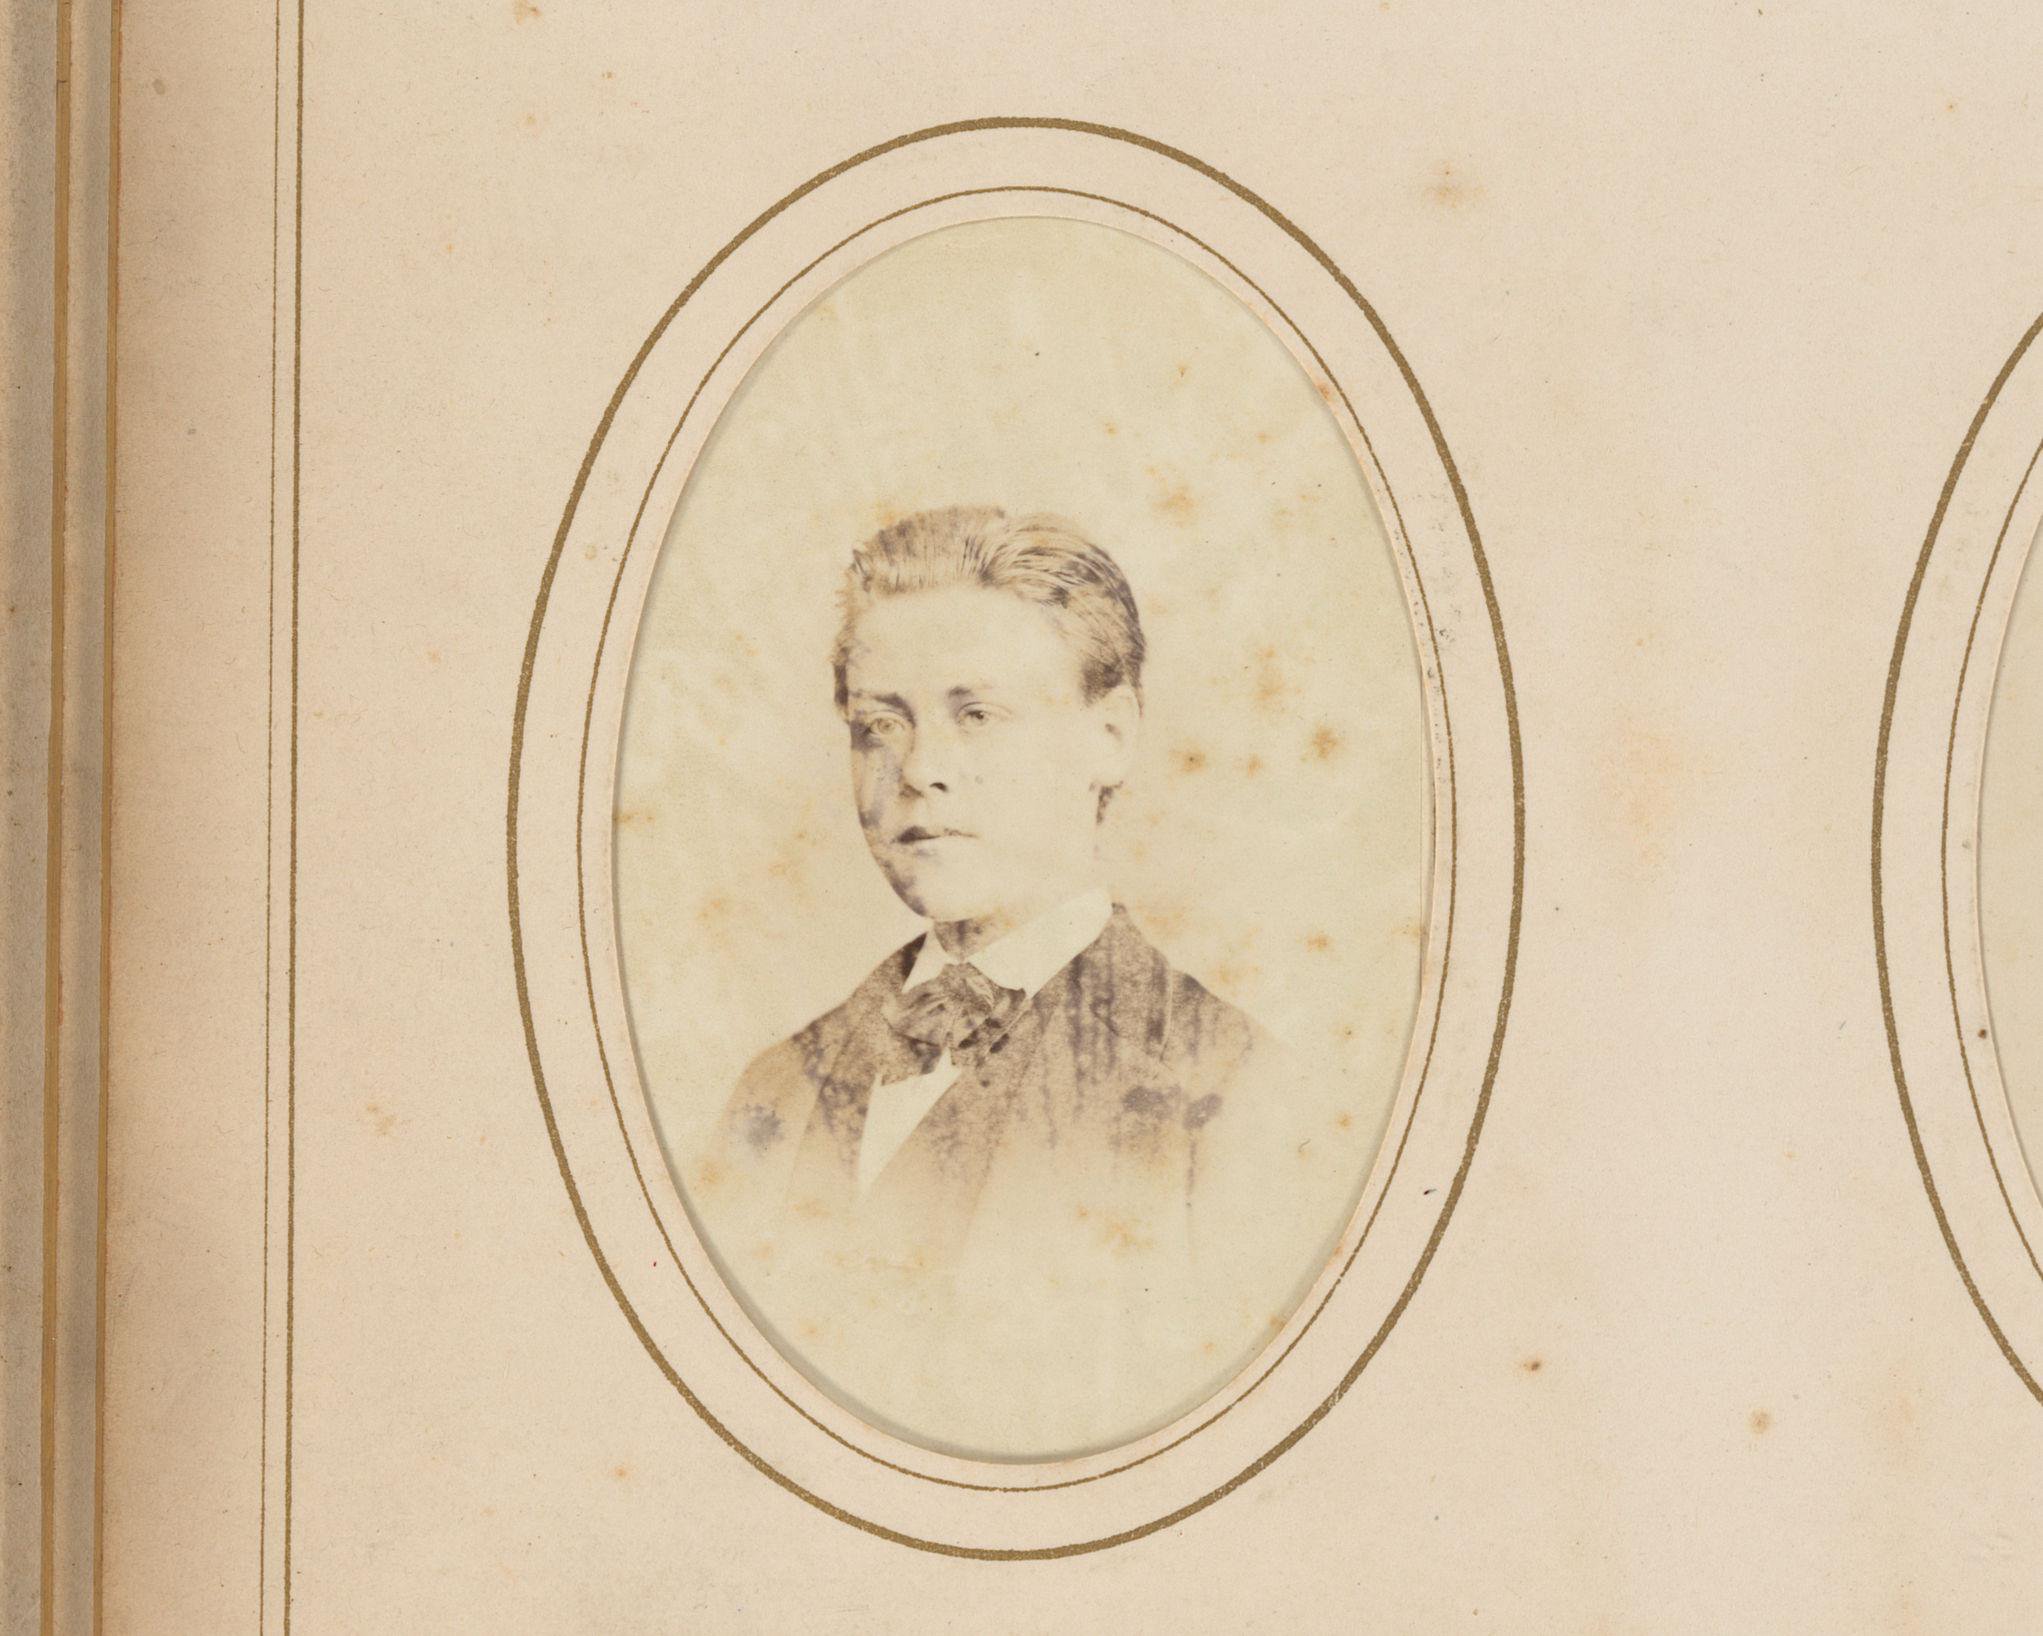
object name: album leaf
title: Portret van een jongen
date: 1807-1871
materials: cardboard, photographic support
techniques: albumen print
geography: netherlands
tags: boy (child between toddler and youth), historical persons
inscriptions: annotation: ‘Juli '71’, inscription: ‘Photogr. Atelier/ van/ Wegner & Mottu/ Kalverstraat D. 26./ AMSTERDAM./ Leijdschestraatweg buiten Catharijnen/ UTRECHT./ STEENDRUKKERY & PHOTOLITHOGRAPHIE/ Keyzersgracht H. H. 479./ AMSTERDAM./ Het cliché wordt voor verdere bestellingen bewaard.’